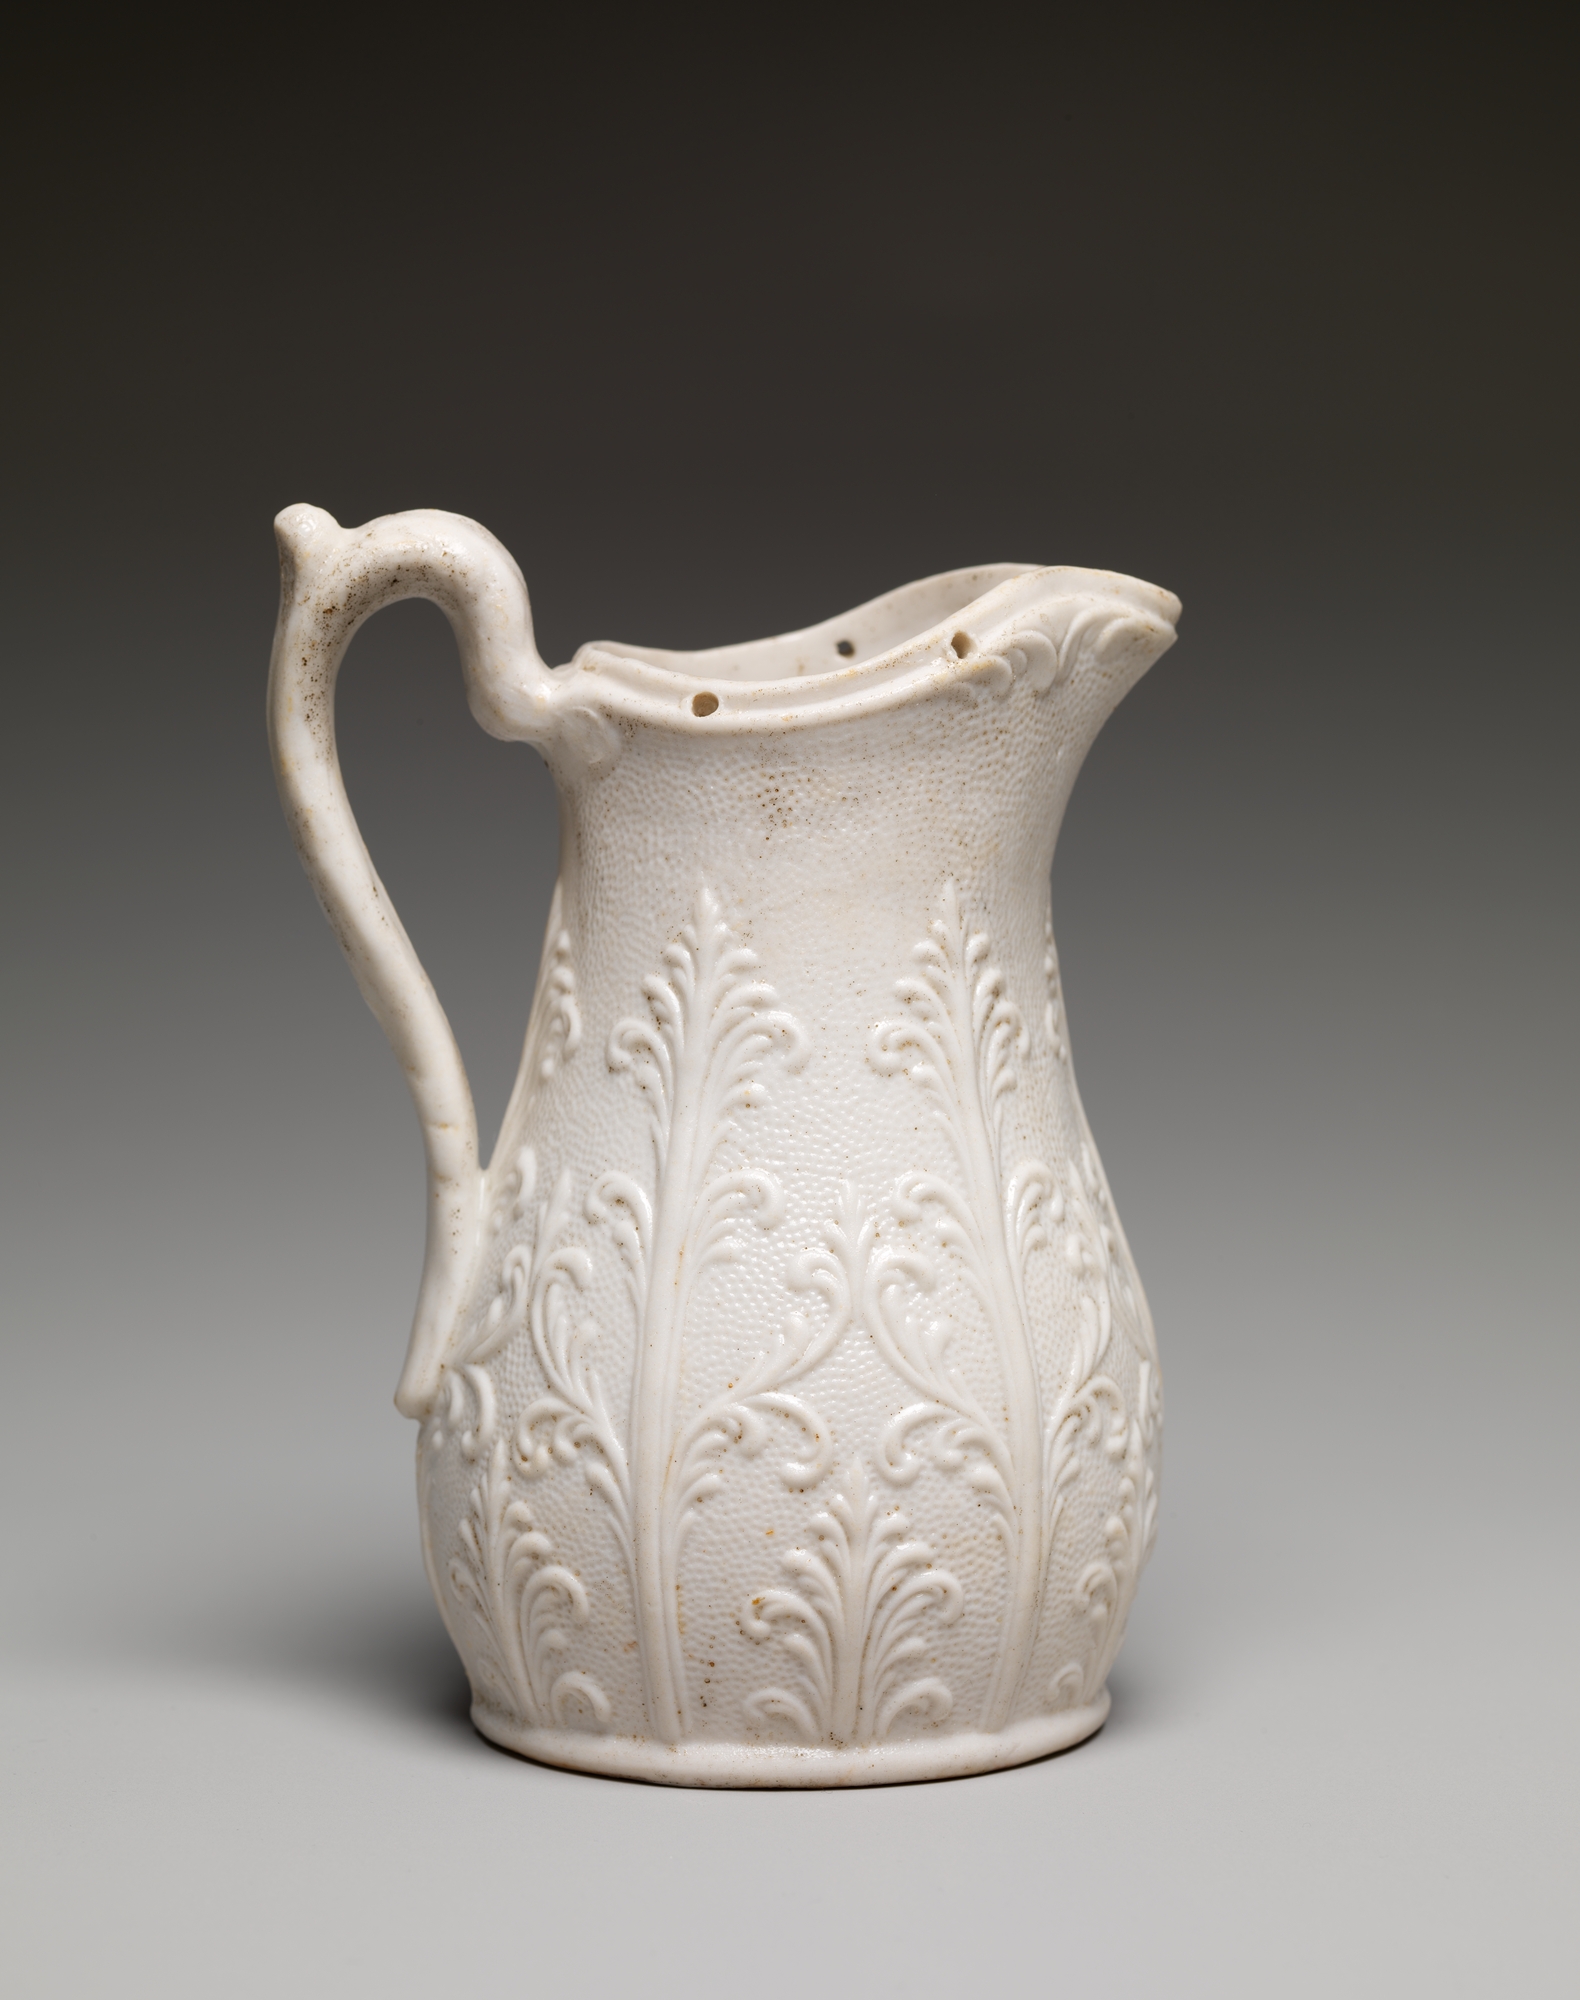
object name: jug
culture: american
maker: united states pottery company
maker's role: maker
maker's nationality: american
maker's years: 1852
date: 1852-1858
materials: porcelain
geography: united states